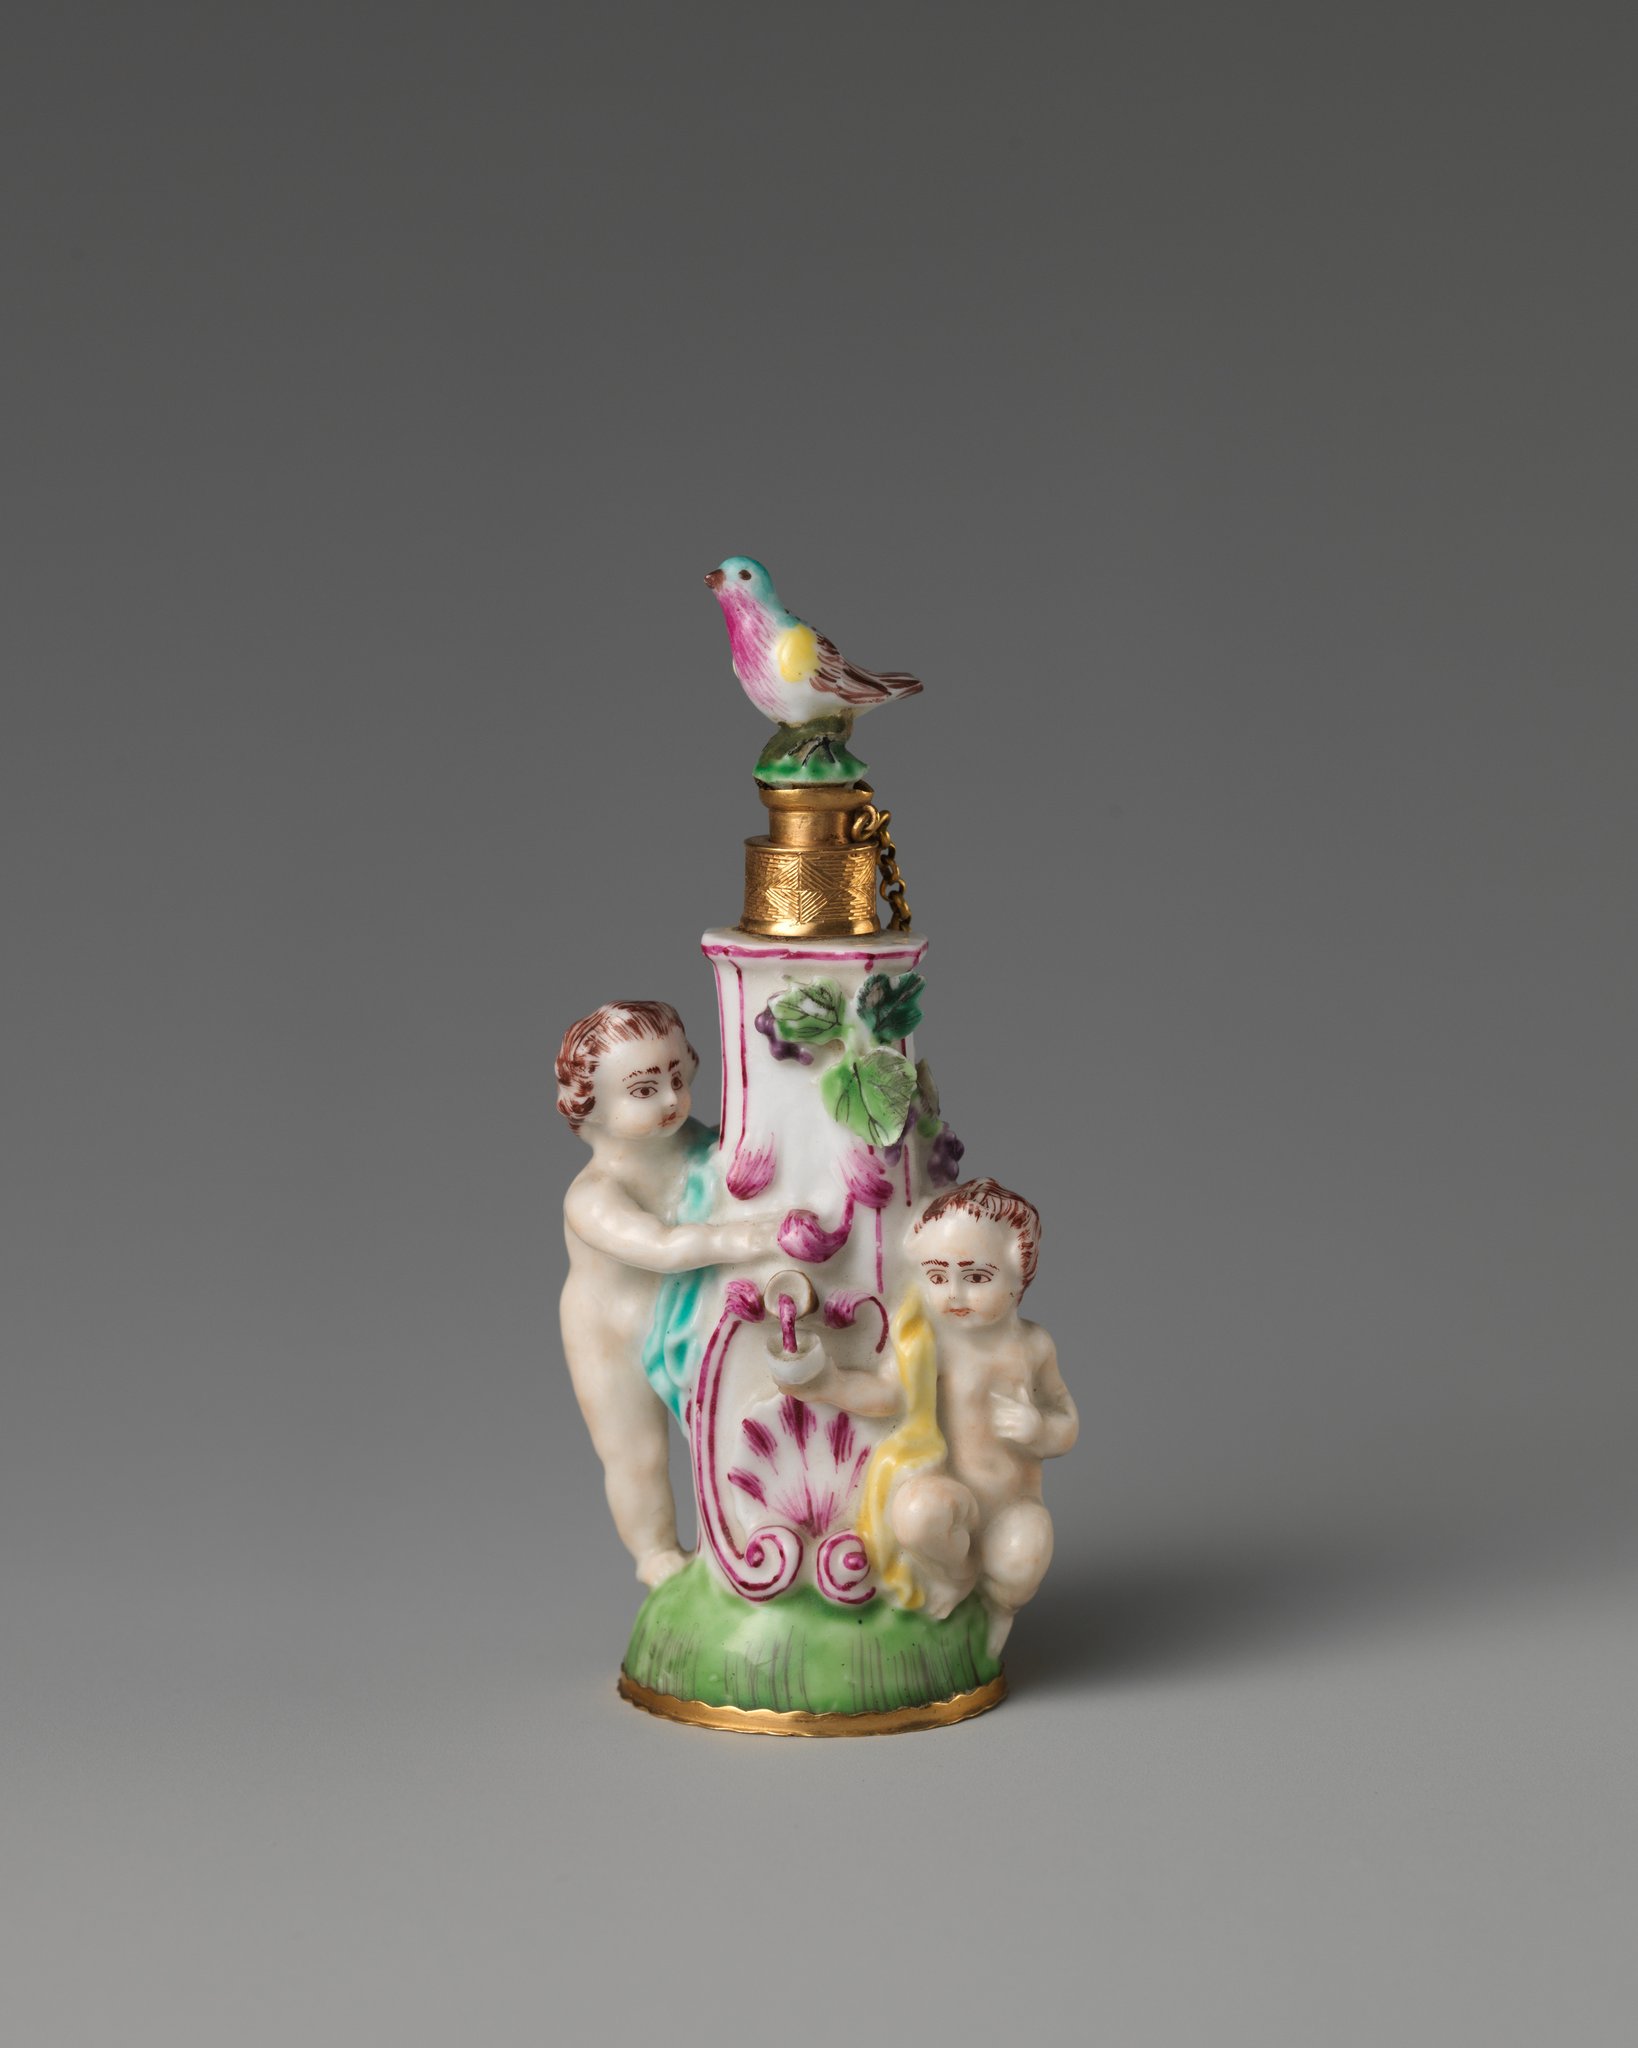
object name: toy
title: Boys at a fountain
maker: saint james's factory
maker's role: maker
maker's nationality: british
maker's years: 1749-1759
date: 1750-1755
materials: soft paste porcelain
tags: birds,fountains,boys